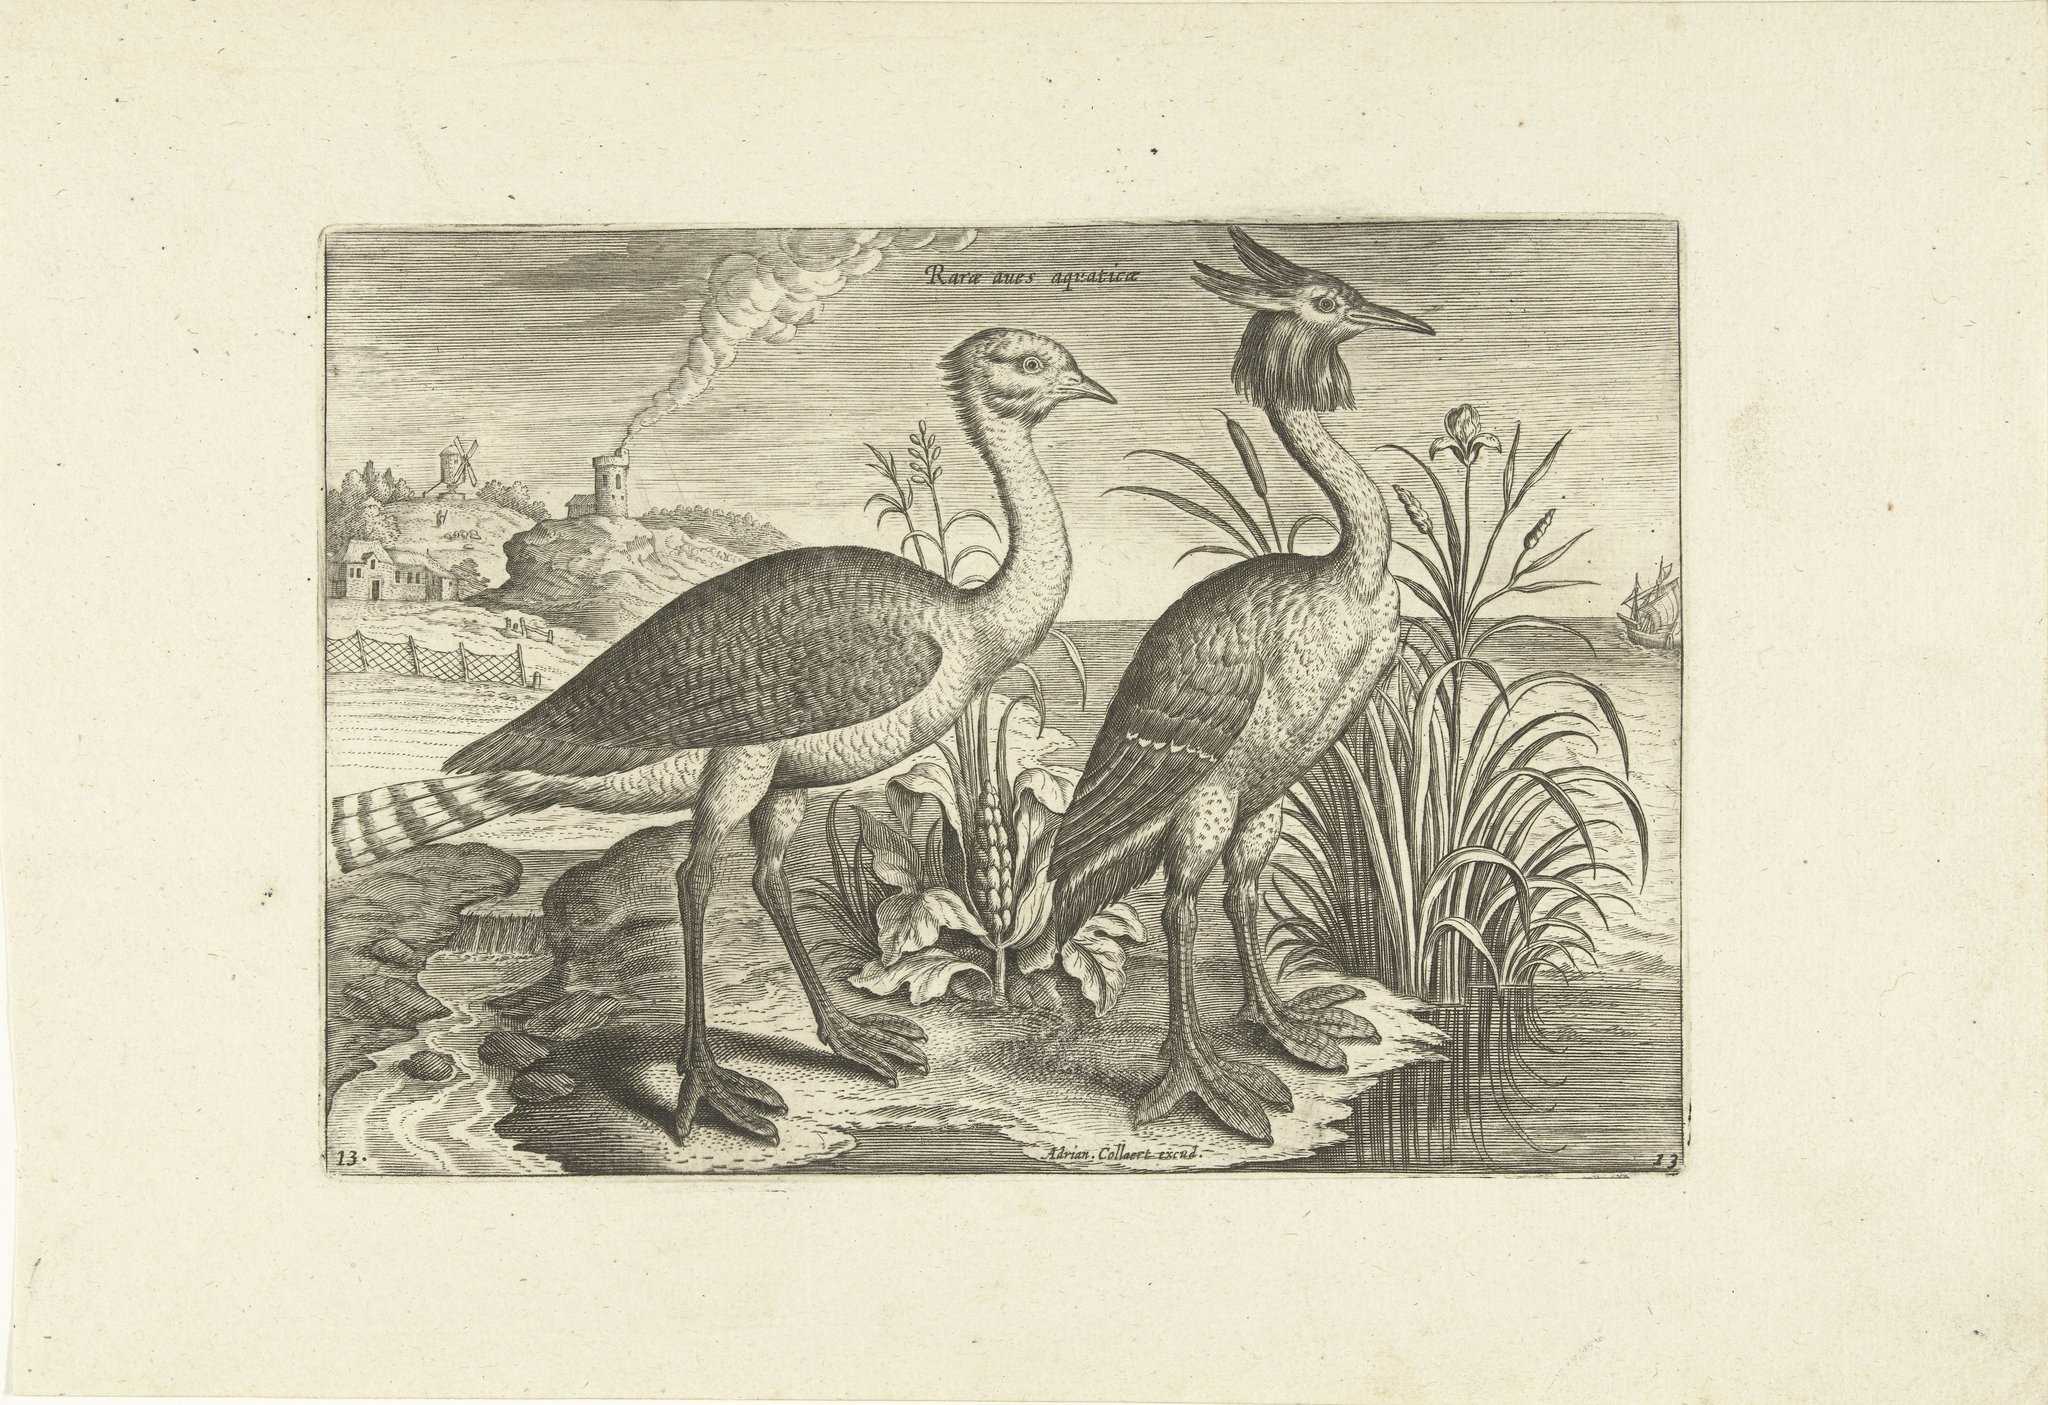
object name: print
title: Avivm vivae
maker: adriaen collaert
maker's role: draughtsman, print maker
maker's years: 1560-1618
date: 1598-1602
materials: paper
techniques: engraving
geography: antwerp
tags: river bank, walker and runner birds: bustard, walker and runner birds (with name)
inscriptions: collector's mark: Lugt 2228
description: Een grote trap en een grote fuit aan de oever van een rivier. Op de achtergrond een landschap. De prent maakt deel uit van een serie met vogels als onderwerp.